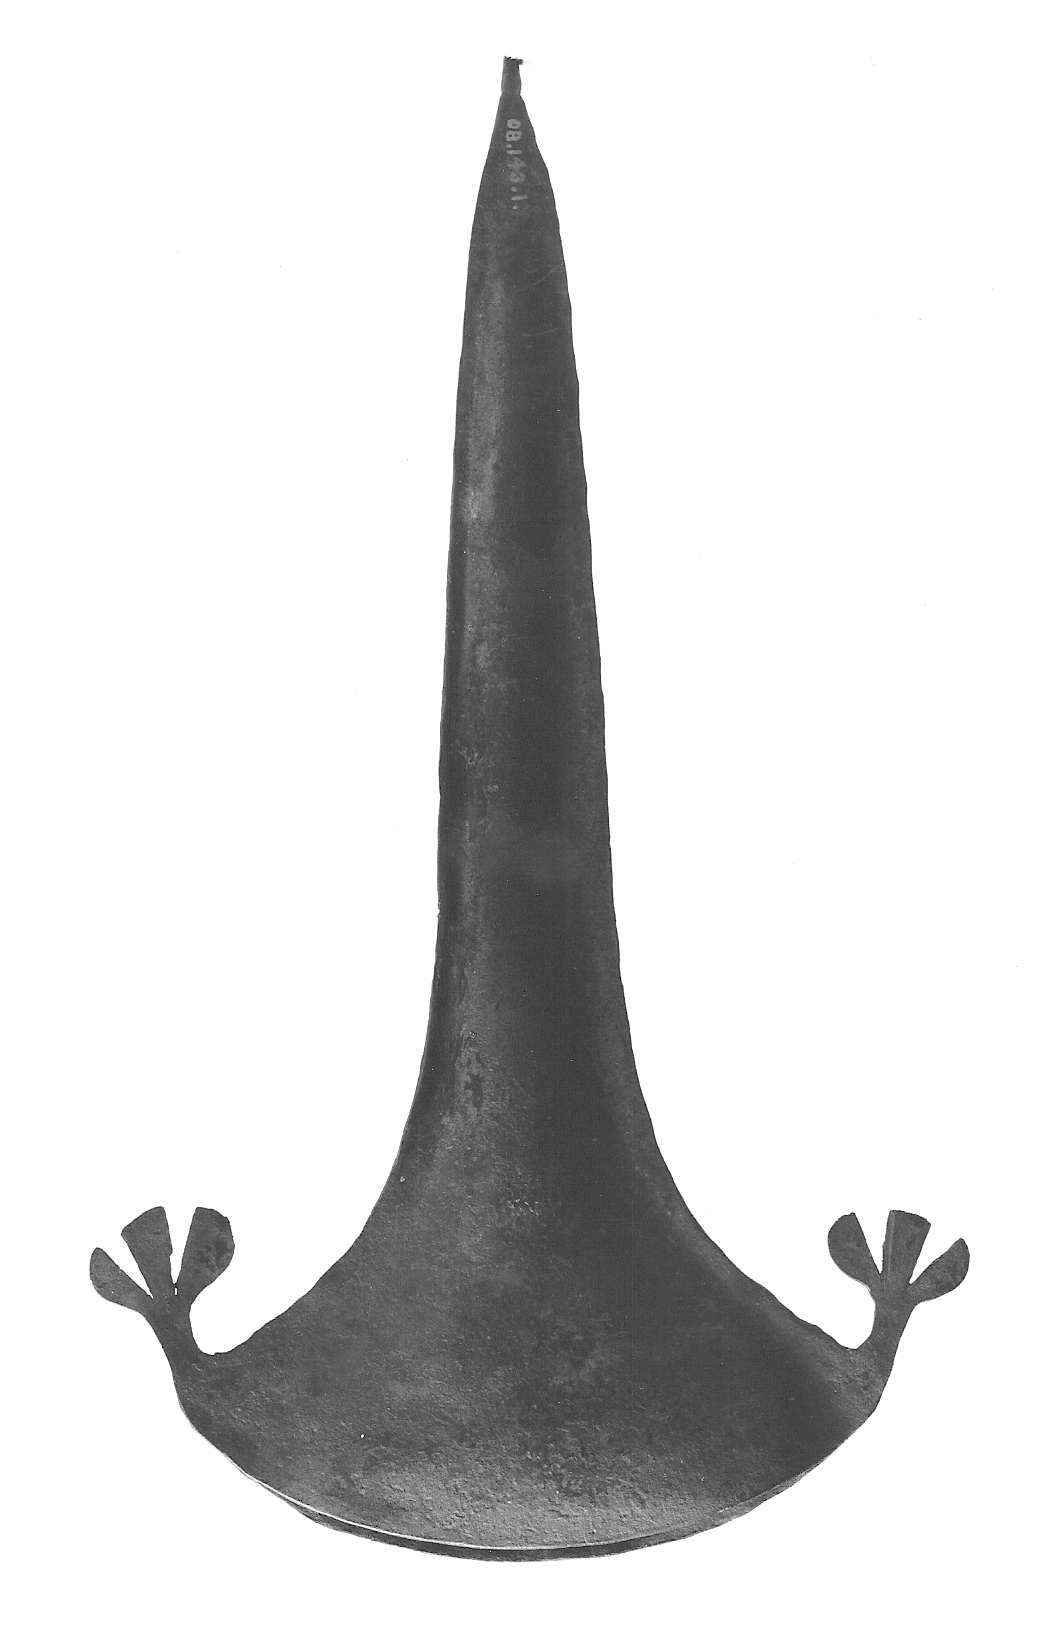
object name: bell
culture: fulani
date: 1801-1900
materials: iron